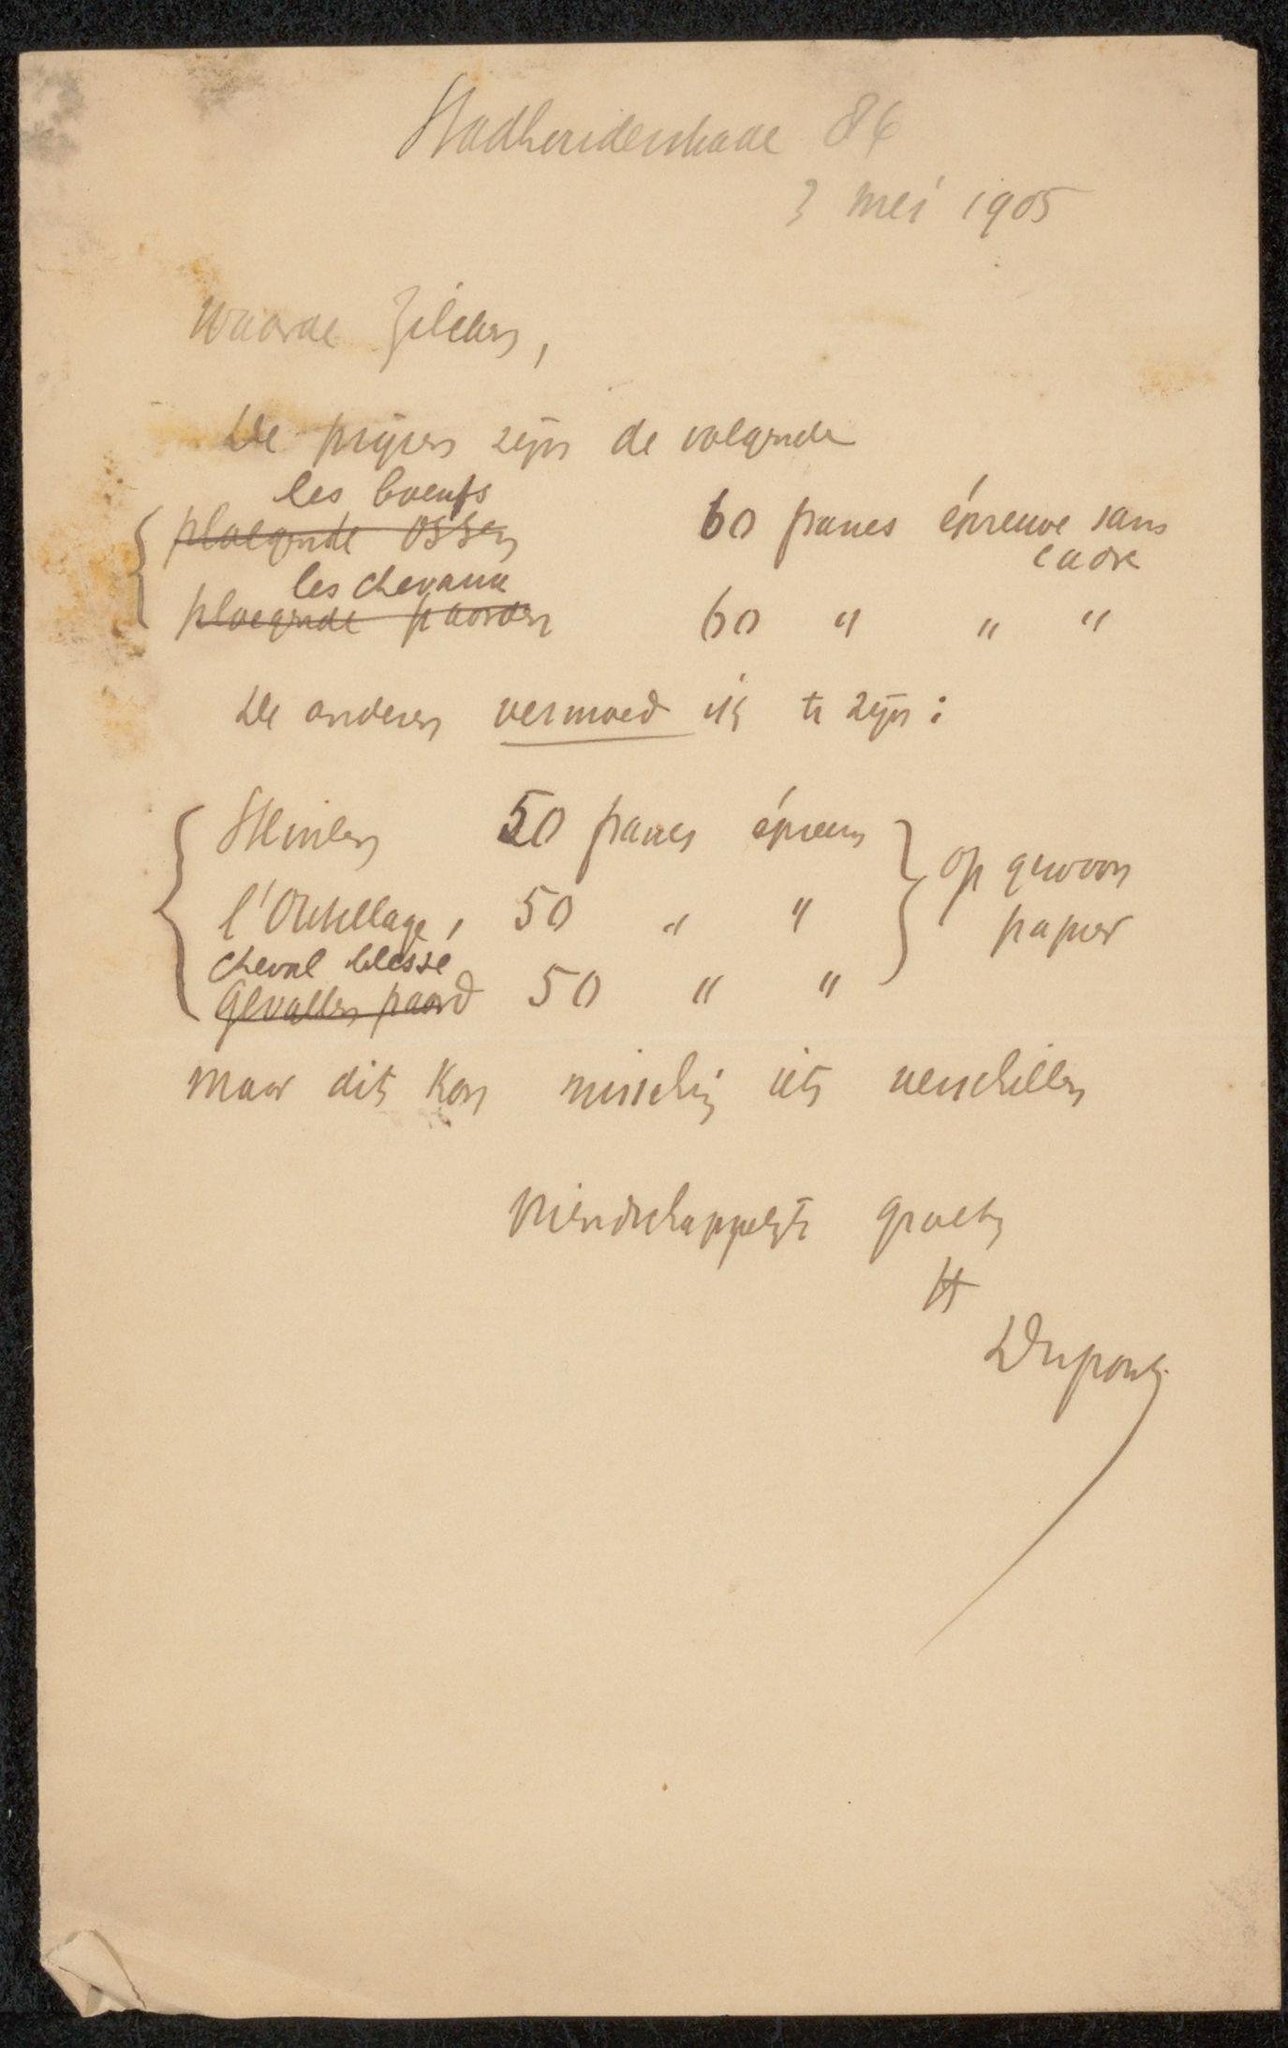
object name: letter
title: Brief aan Philip Zicken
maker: pieter dupont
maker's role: draughtsman, print maker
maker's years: 1870-1911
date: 1905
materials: cardboard, ink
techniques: pen, writing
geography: amsterdam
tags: painter, philip zilcken, drawing, money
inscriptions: collector's mark: ‘RPK’, watermark